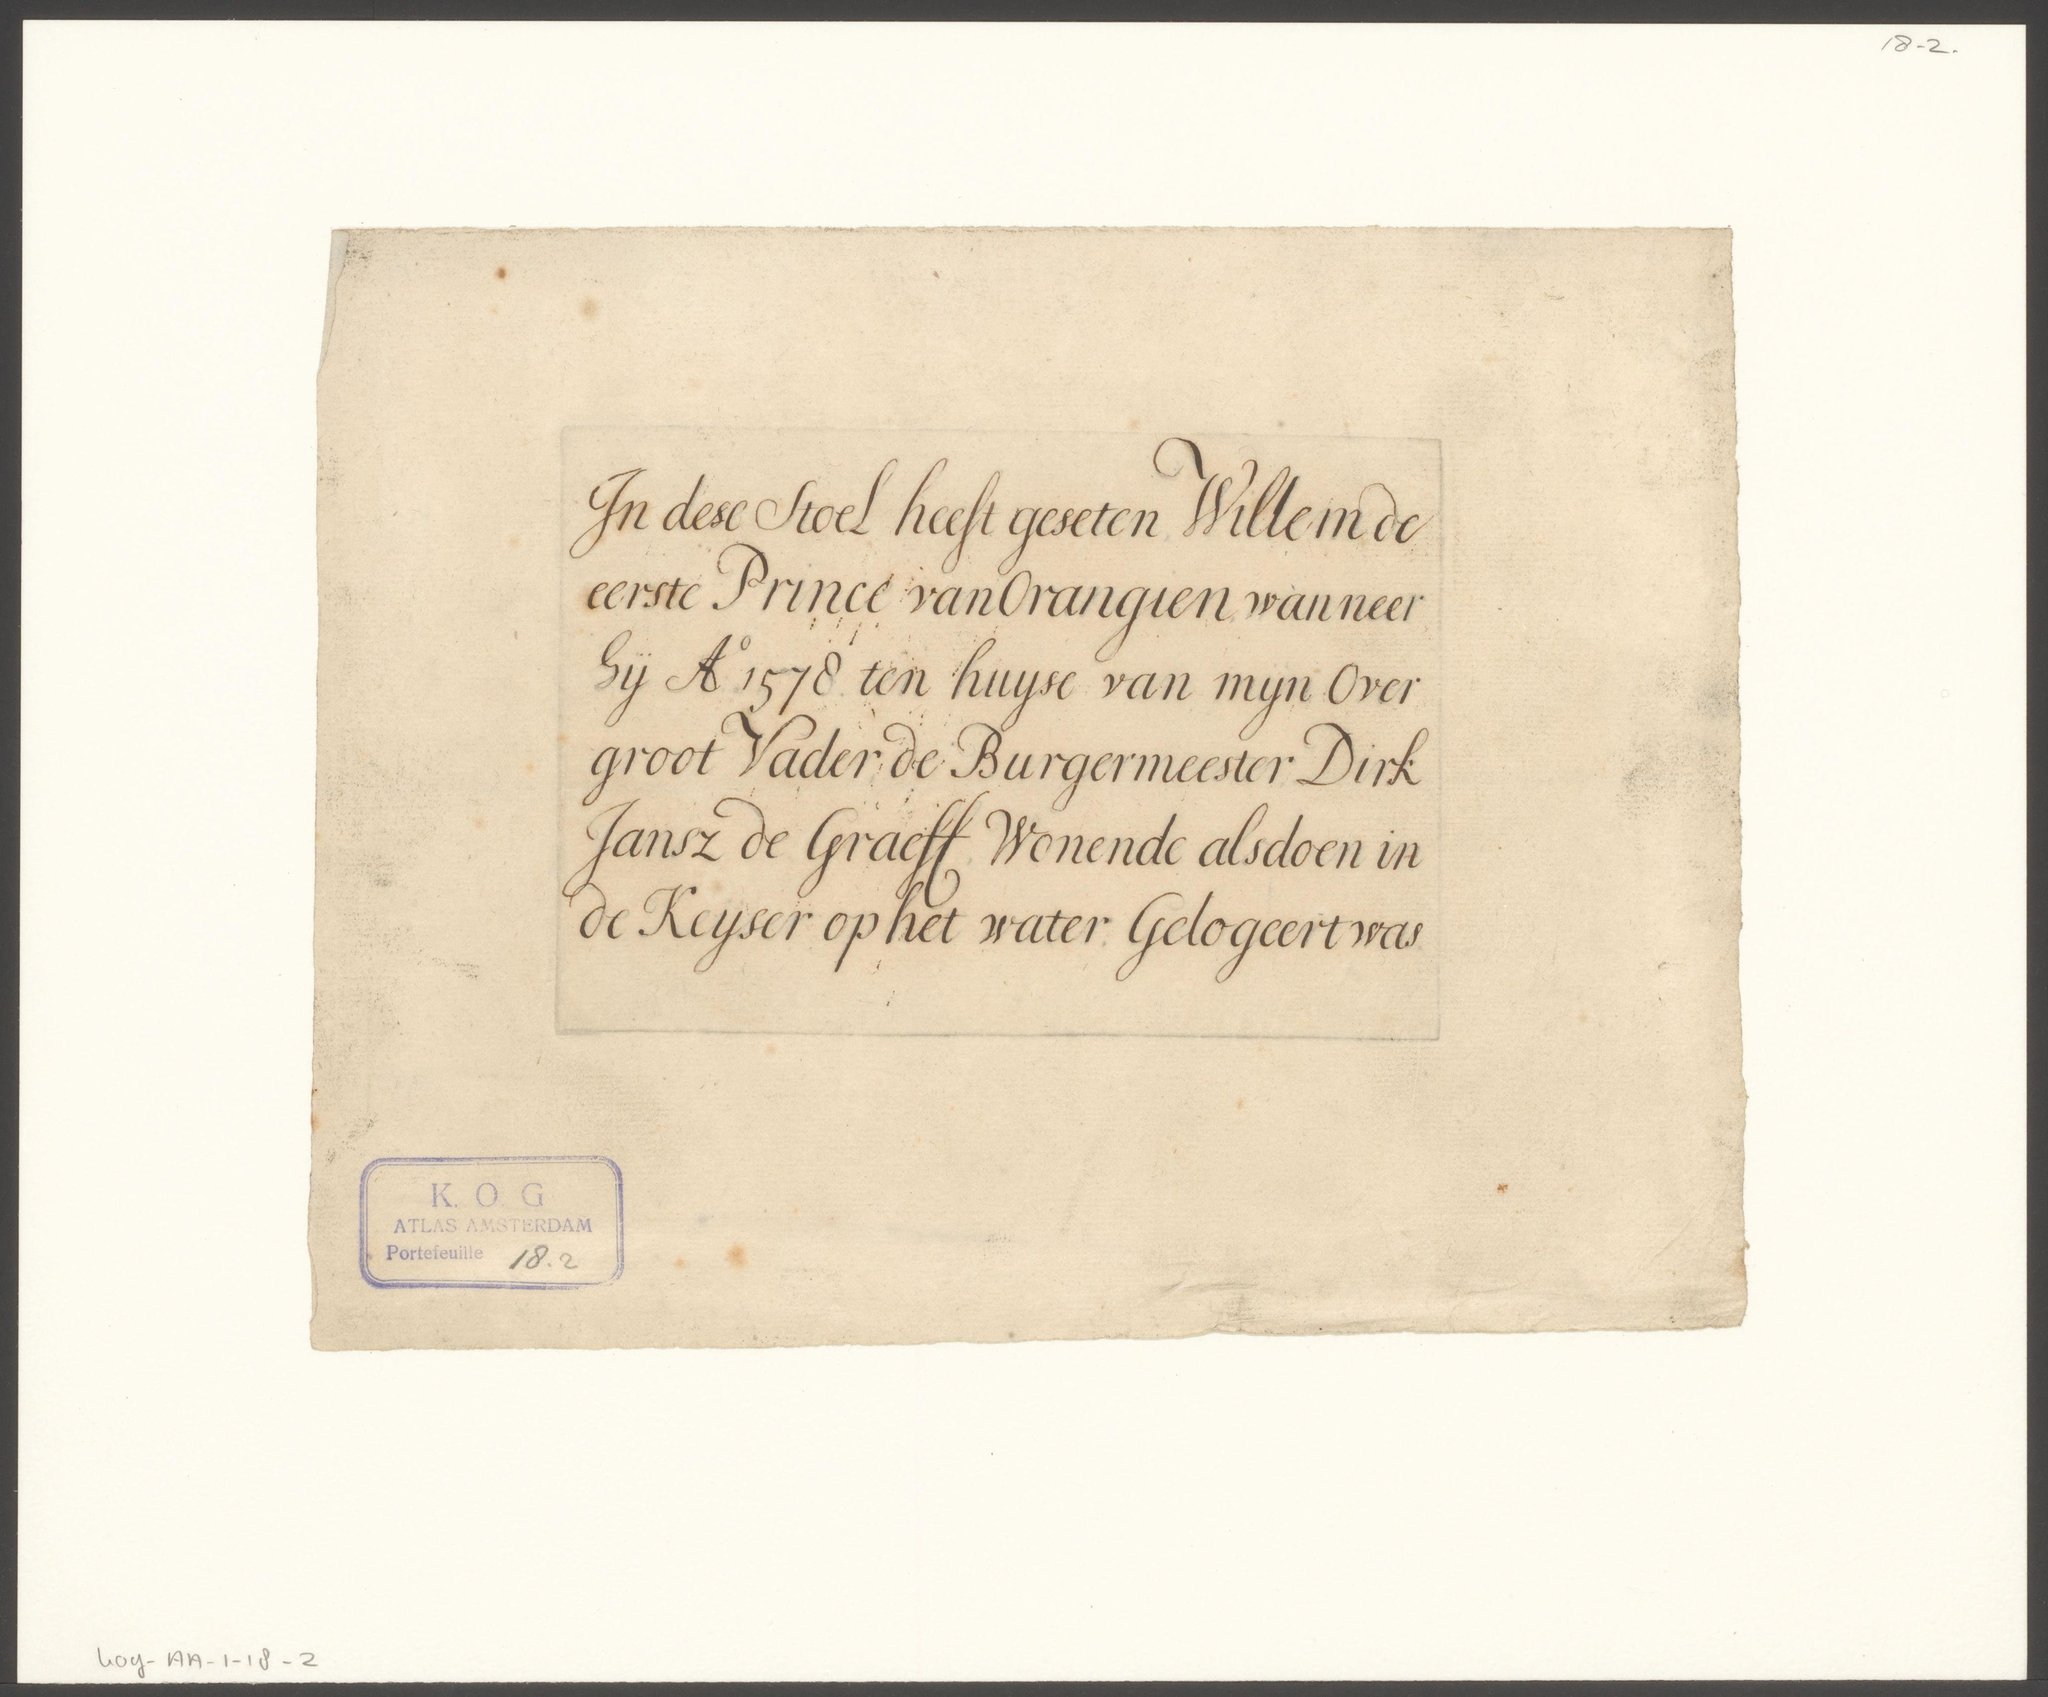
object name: print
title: Tekstblad over het gebruik van een armstoel door Willem van Oranje in het bezit van burgemeester Diederik Jansz. Graeff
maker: Anonymous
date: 1700-1799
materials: ink, paper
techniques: engraving, pen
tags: delft, william i (prince of orange), politician, handwriting, written text, amsterdam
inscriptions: collector's mark: ‘18.2’ Lugt 1641b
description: Onderwerpsrubriek binnen de Atlas Amsterdam: Herinneringen aan regeringsleden en hunne huisgezinnen [voor 1800].